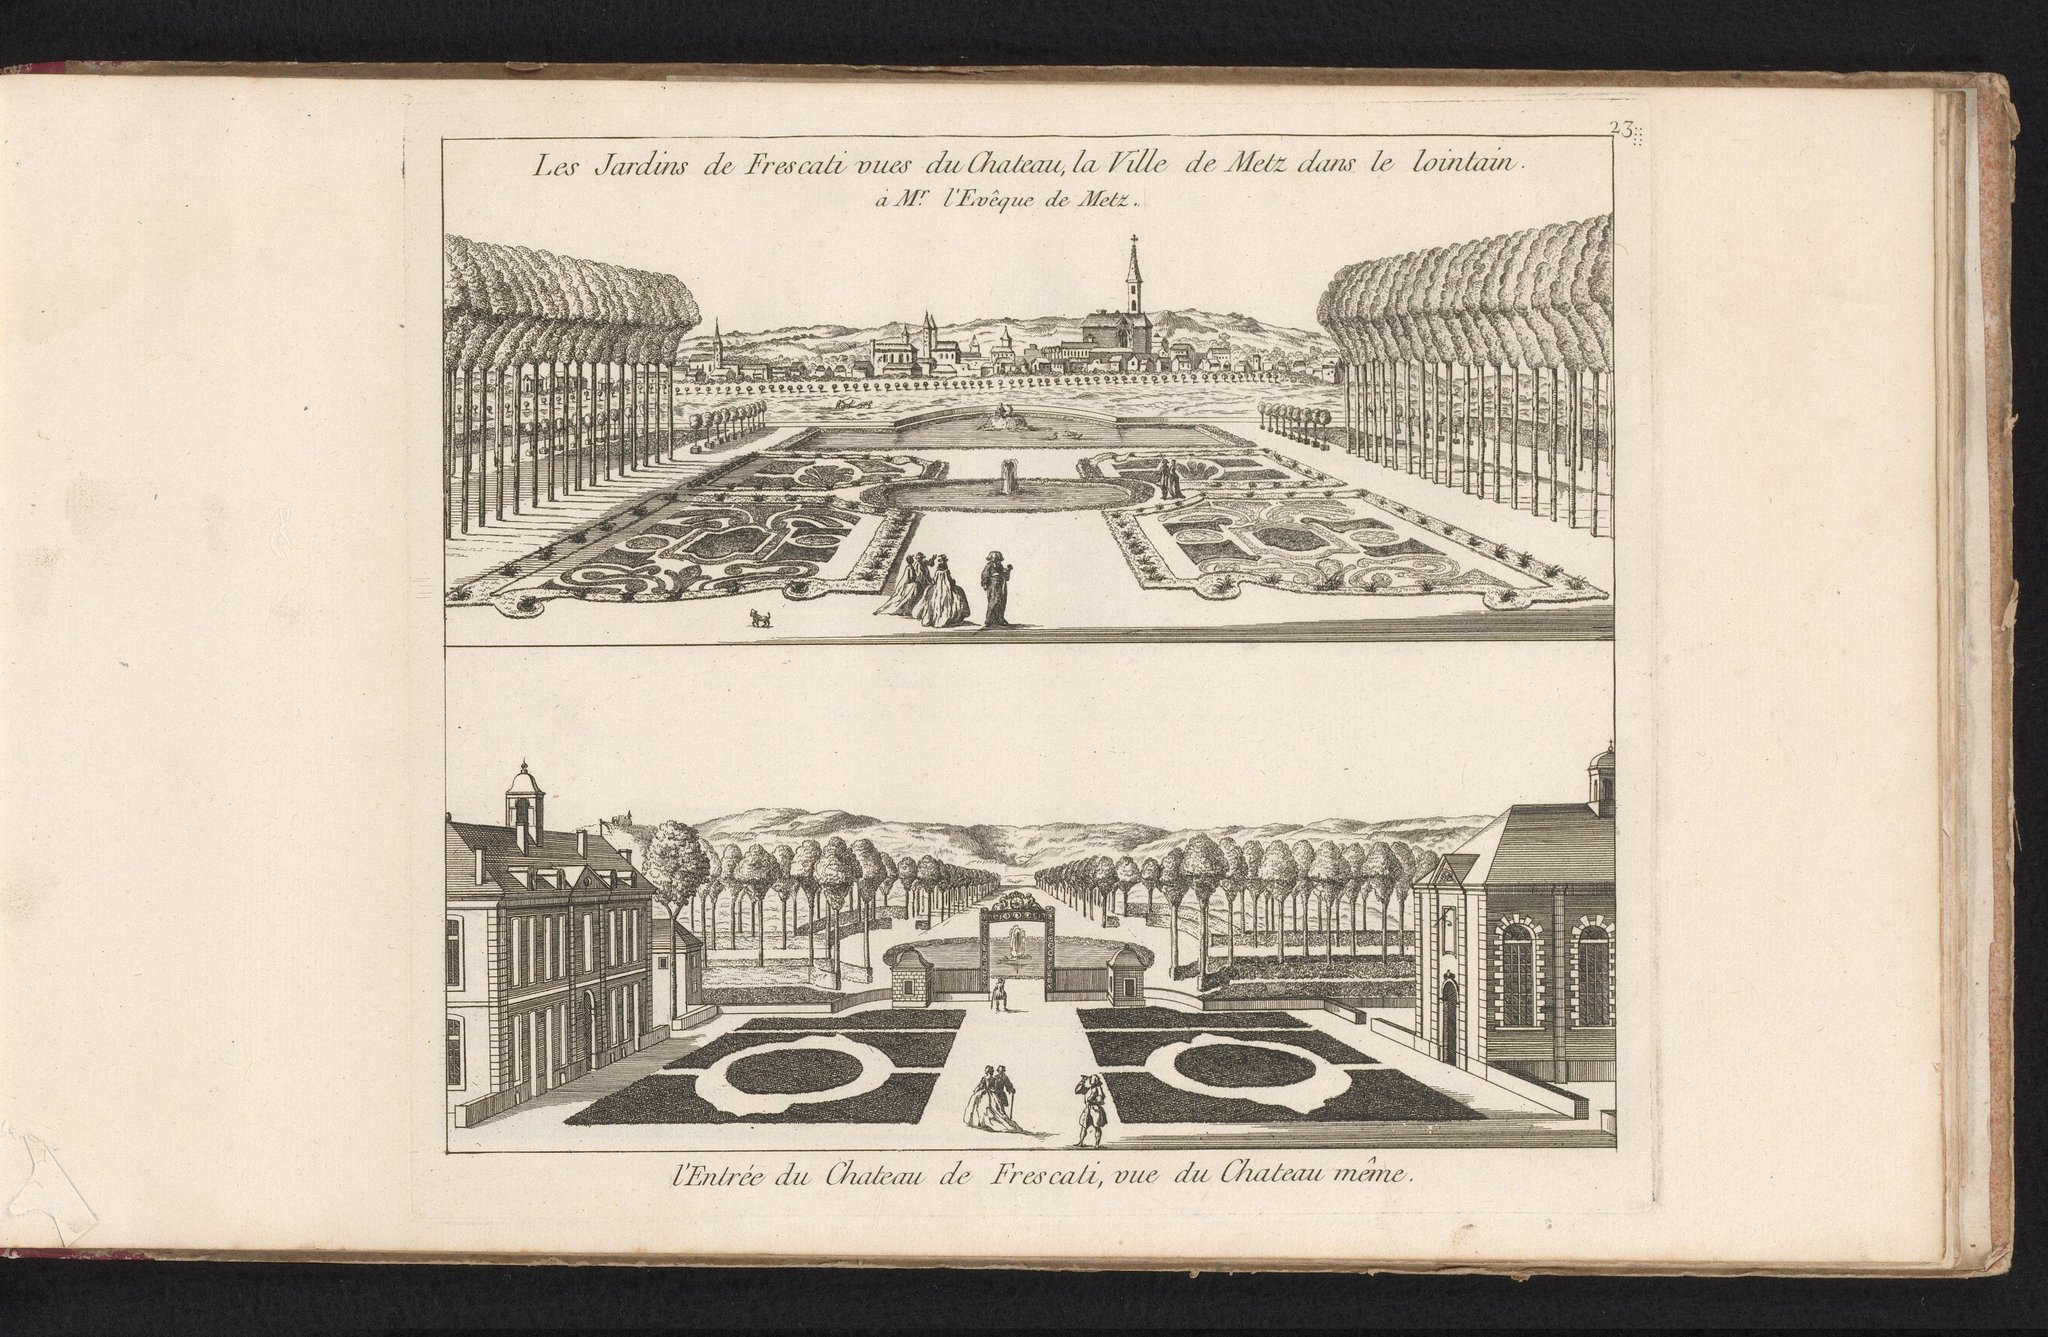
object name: print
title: Landschapstuinen in Chinees-Engelse stijl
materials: paper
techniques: engraving, etching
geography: paris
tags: castle, garden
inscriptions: collector's mark: Lugt 2228, collector's mark: Lugt 2760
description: De serie 'Jardins anglo-chinois à la mode' verscheen in totaal in 21 zogeheten 'cahiers' (afleveringen). De huidige prent komt uit het achtste 'cahier'. Het Rijksmuseum Amsterdam bezit drie banden met daarin in totaal zes 'cahiers' van deze reeks. In de documentatie wordt verwezen naar een in de bibliotheek van het Rijksmuseum Amsterdam aanwezige facsimile van het complete werk.